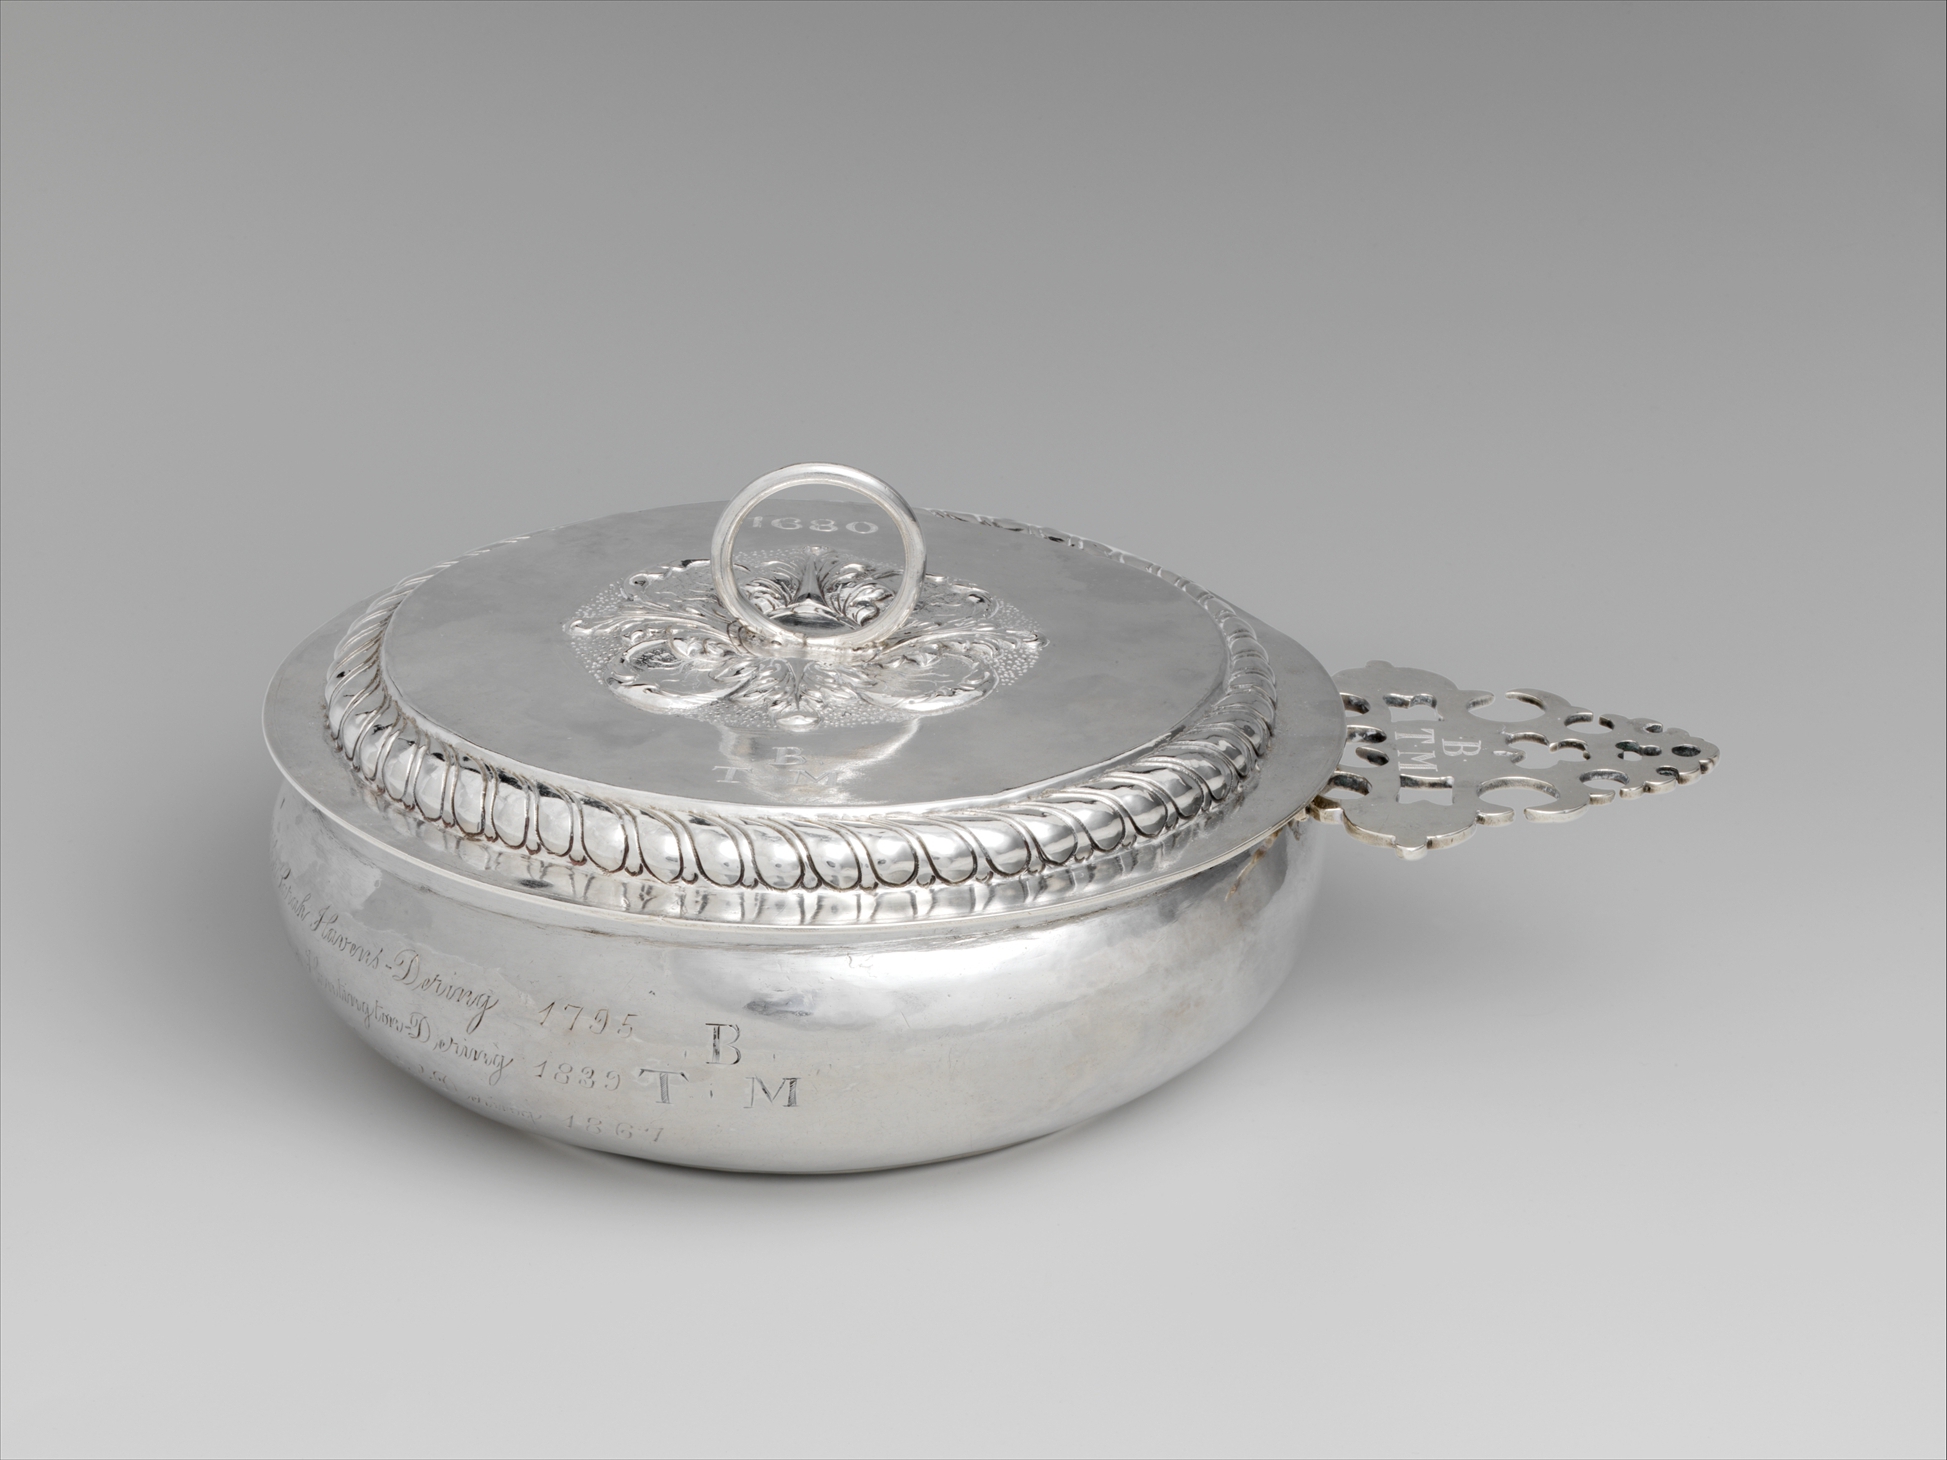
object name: porringer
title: Porringer with Cover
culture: american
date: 1700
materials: silver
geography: new england